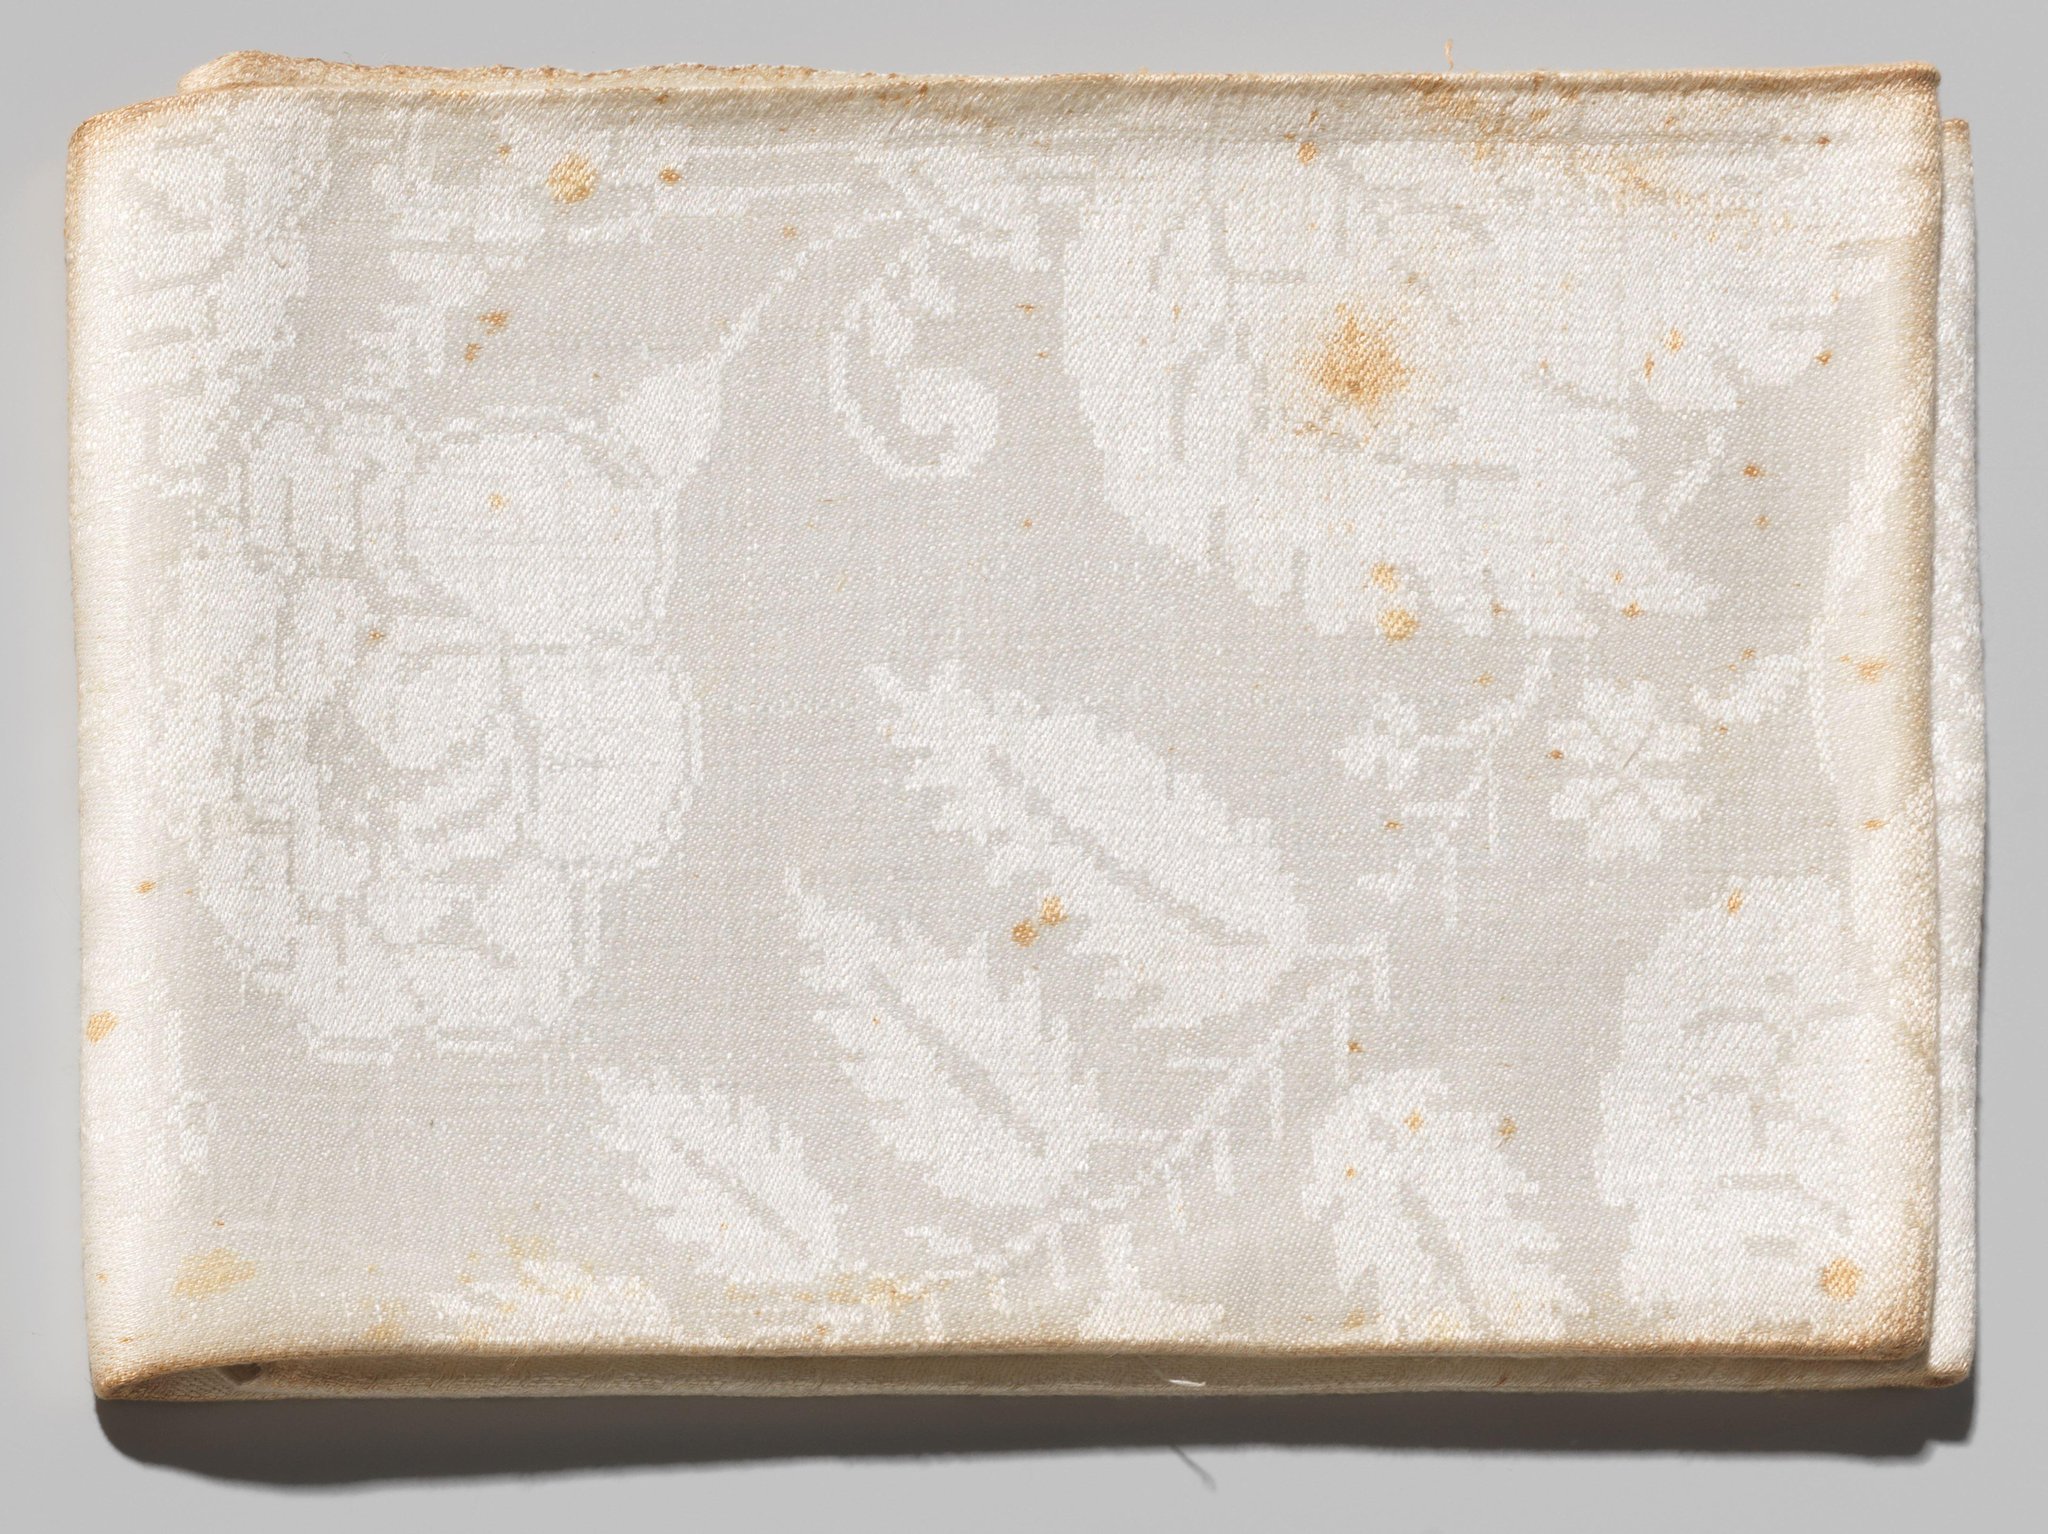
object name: napkin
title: Servet met bloempatroon en rasterwerk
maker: Anonymous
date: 1700-1749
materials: linen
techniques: damask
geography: southern netherlands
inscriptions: mark: ‘AMH 12’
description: Servet van linnendamast met bloempatroon en rasterwerk. Op een spitsovaal veld, over de volle breedte, staat een console (?) met rasterwerk, waaruit een symmetrisch boeket ontspruit, bestaande uit een ananasvormige bloem, een bladrank en een bladrozet waarop drie rozen. Het veld is begrensd door een brede band met netwerkvulling en rand van bladrank en enkele bloemen. In de zwikken onder andere anjers. Dubbele staande randen: de binnenste met rasterfond en lopende voluutrank, de buitenste met kantschulpen; daarbuiten: blokkenrand.